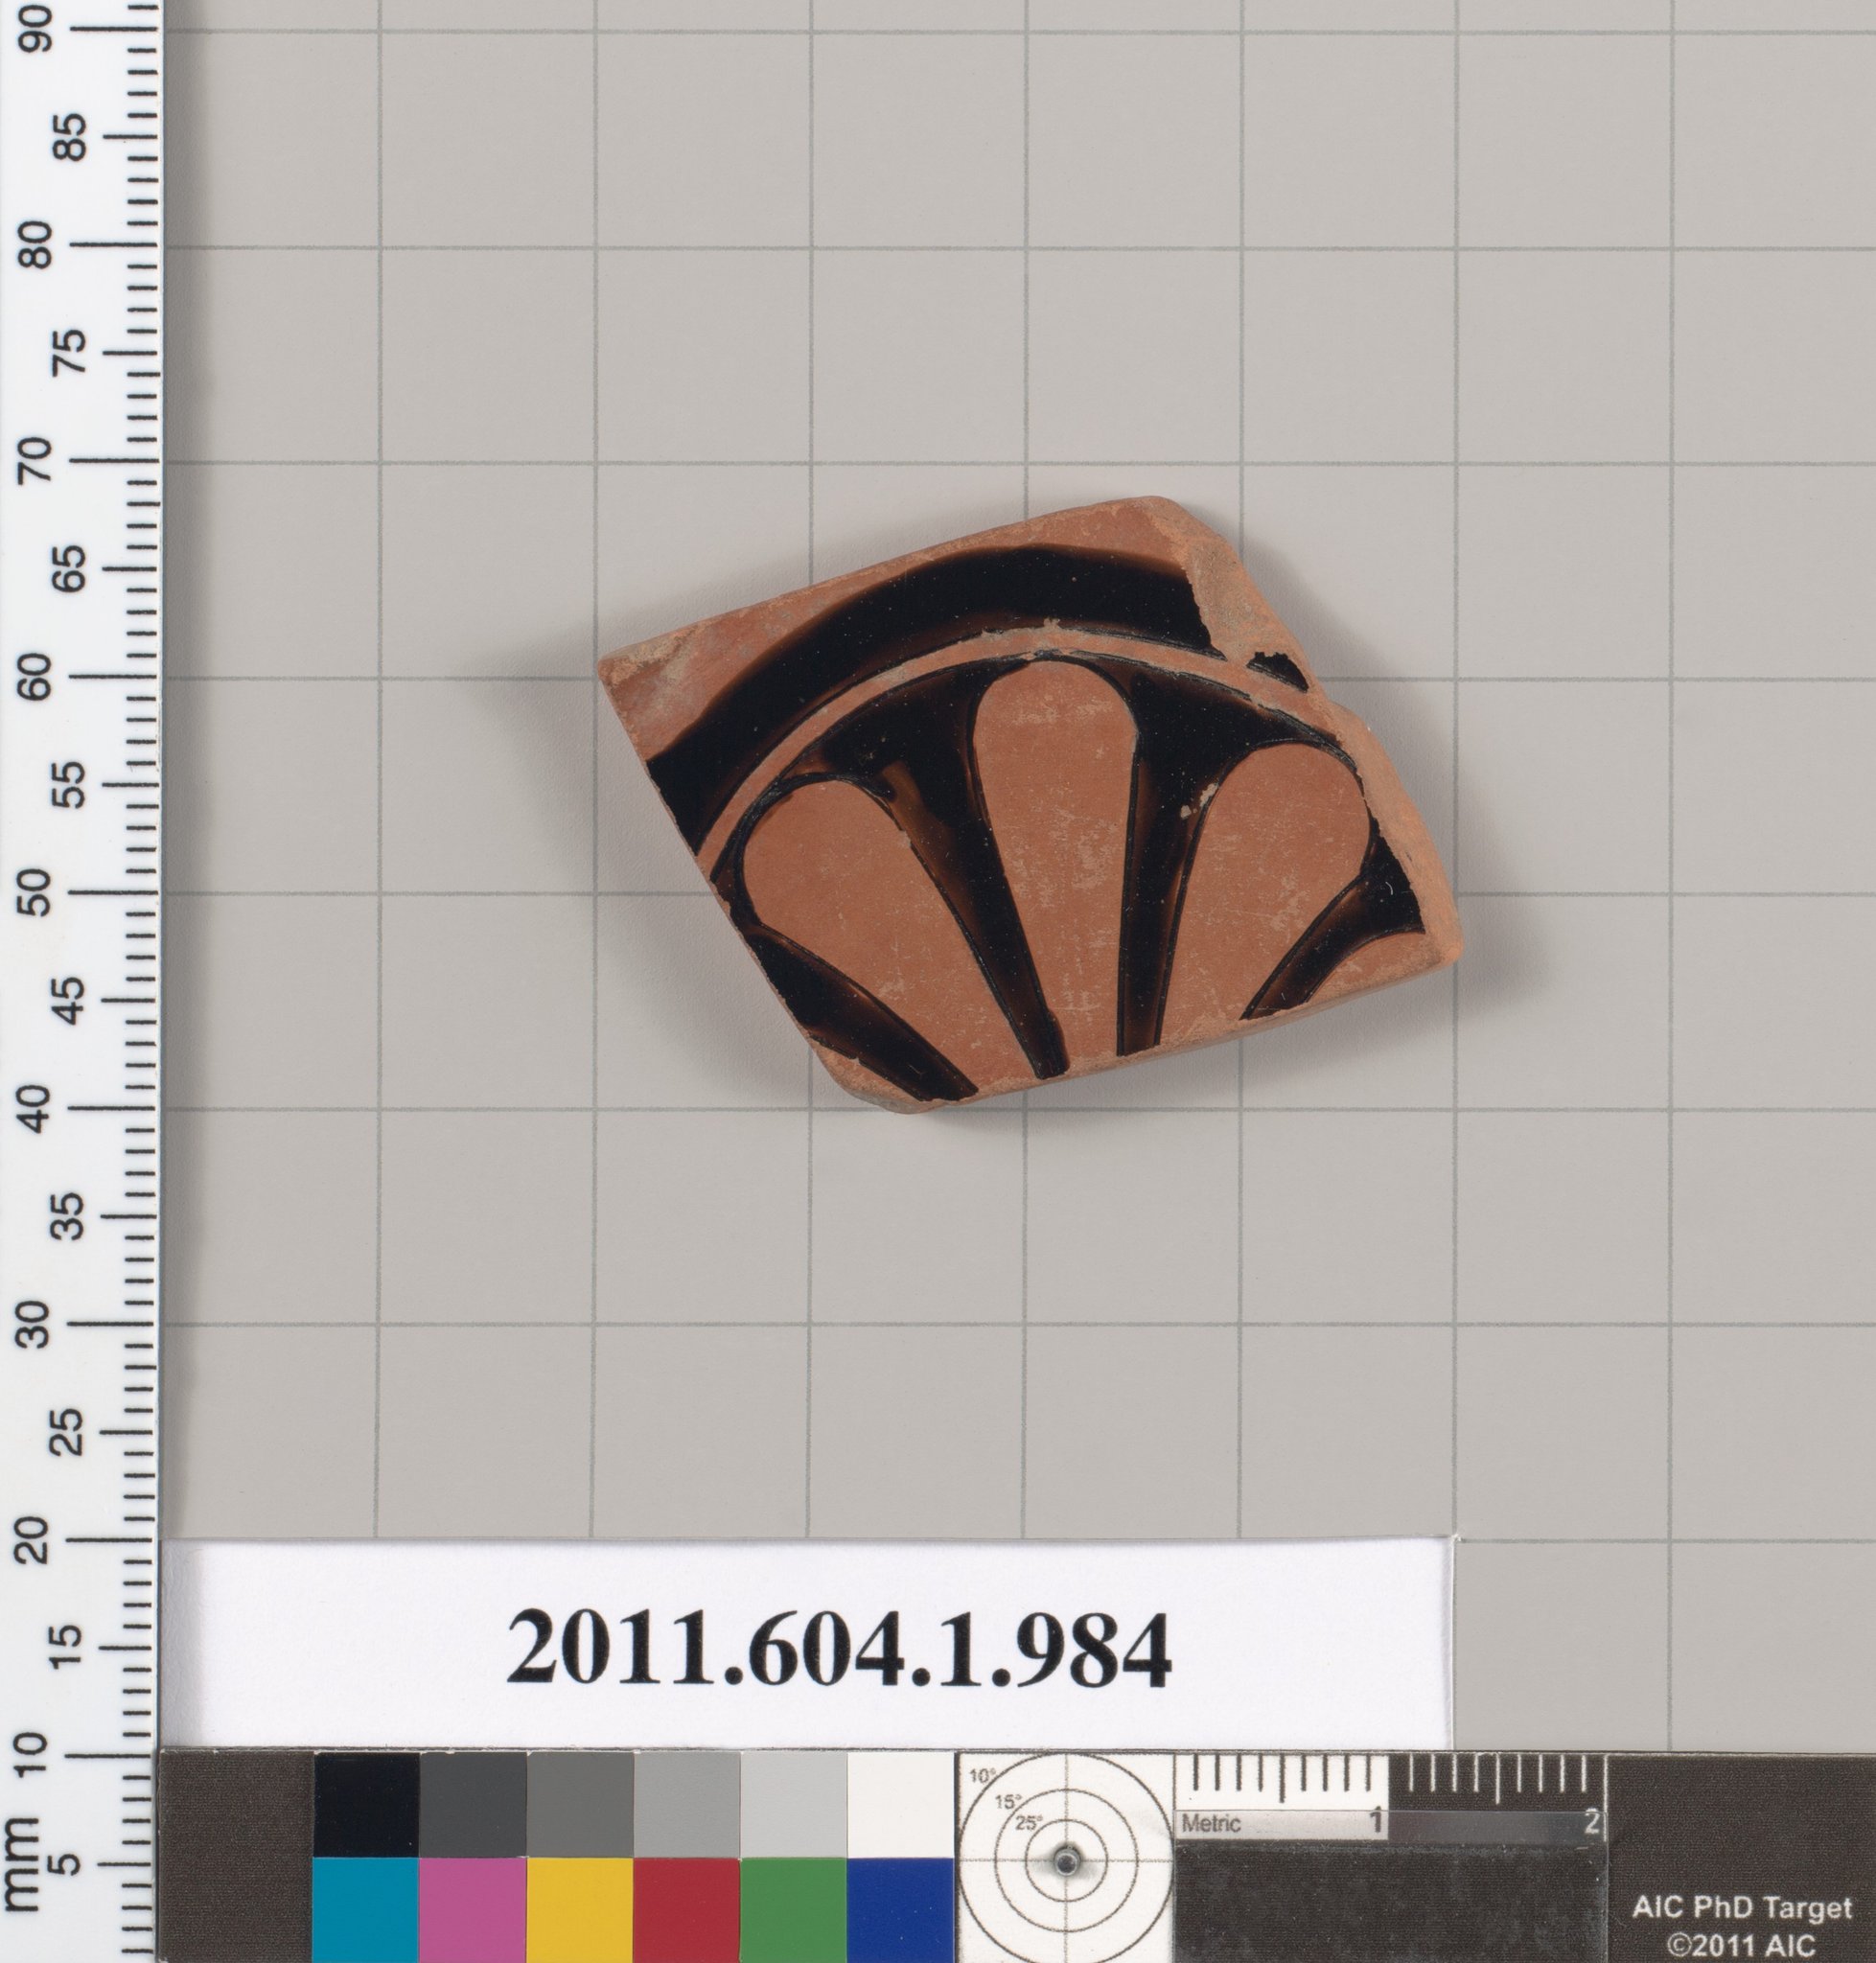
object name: kylix fragment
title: Terracotta fragment of a kylix (drinking cup)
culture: greek, attic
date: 500-476 BCE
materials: terracotta